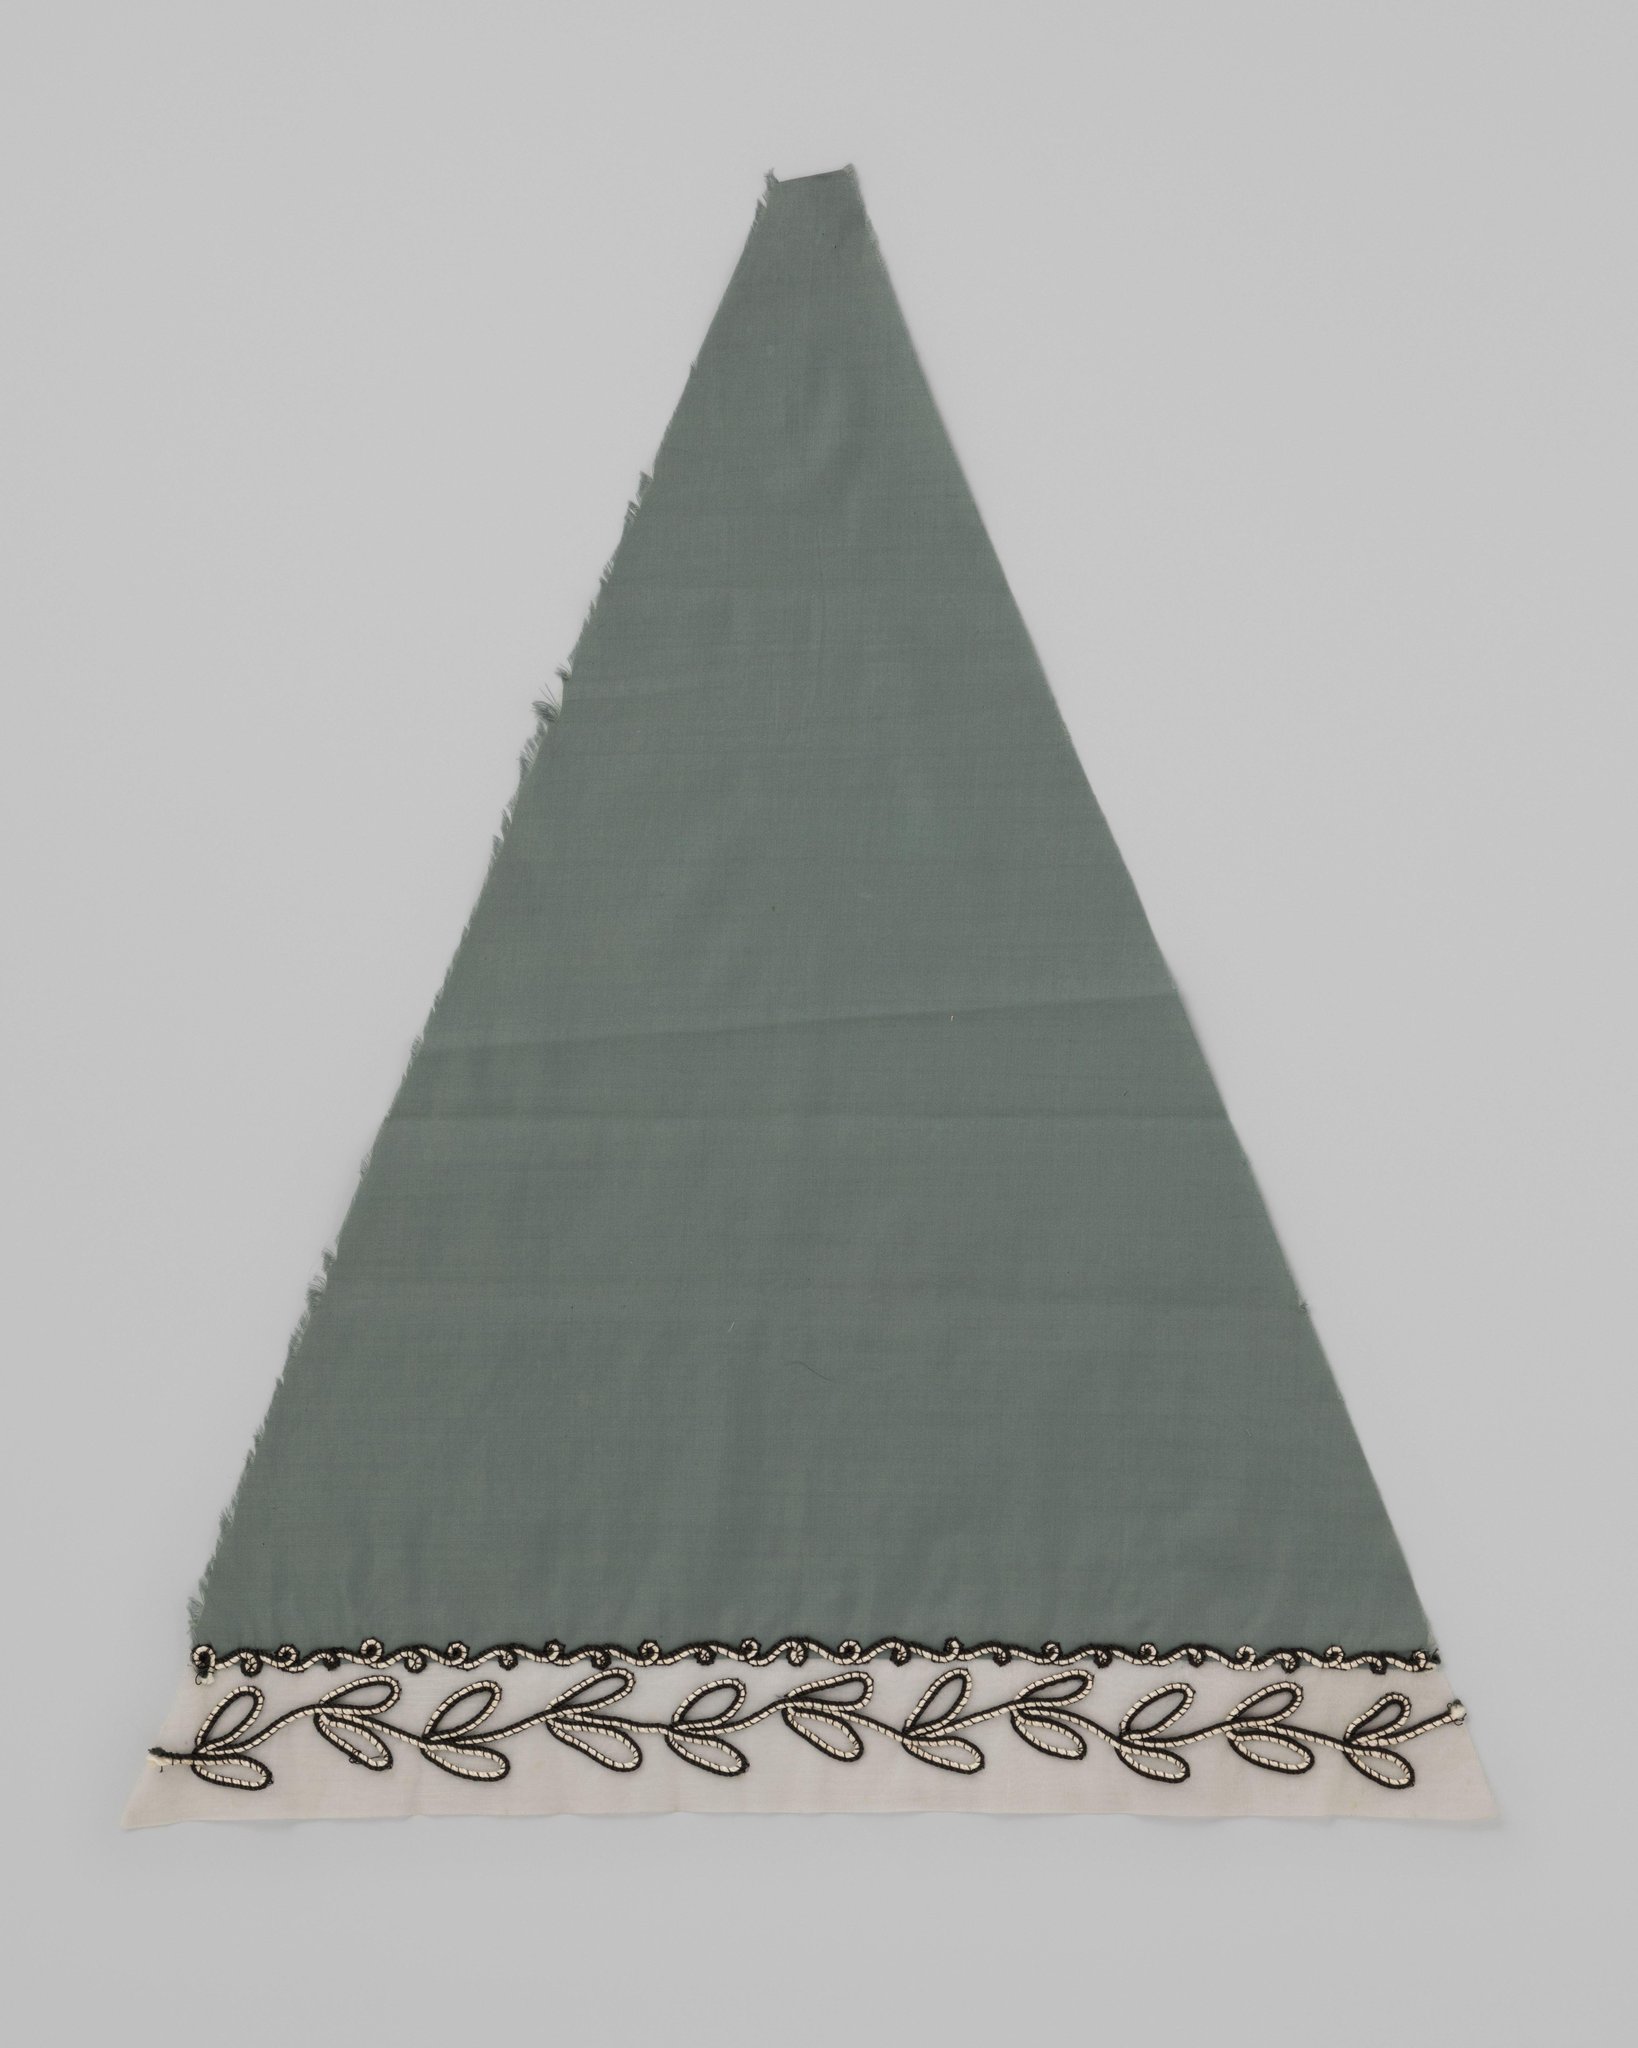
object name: parasoldek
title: Sector van een parasoldek van zachtgroene katoen, met een met woldraad geborduurde batisten rand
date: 1885-1900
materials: cotton, wool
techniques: embroidered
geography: france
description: Sector van een parasoldek van zachtgroene katoen, met een met woldraad geborduurde batisten rand.